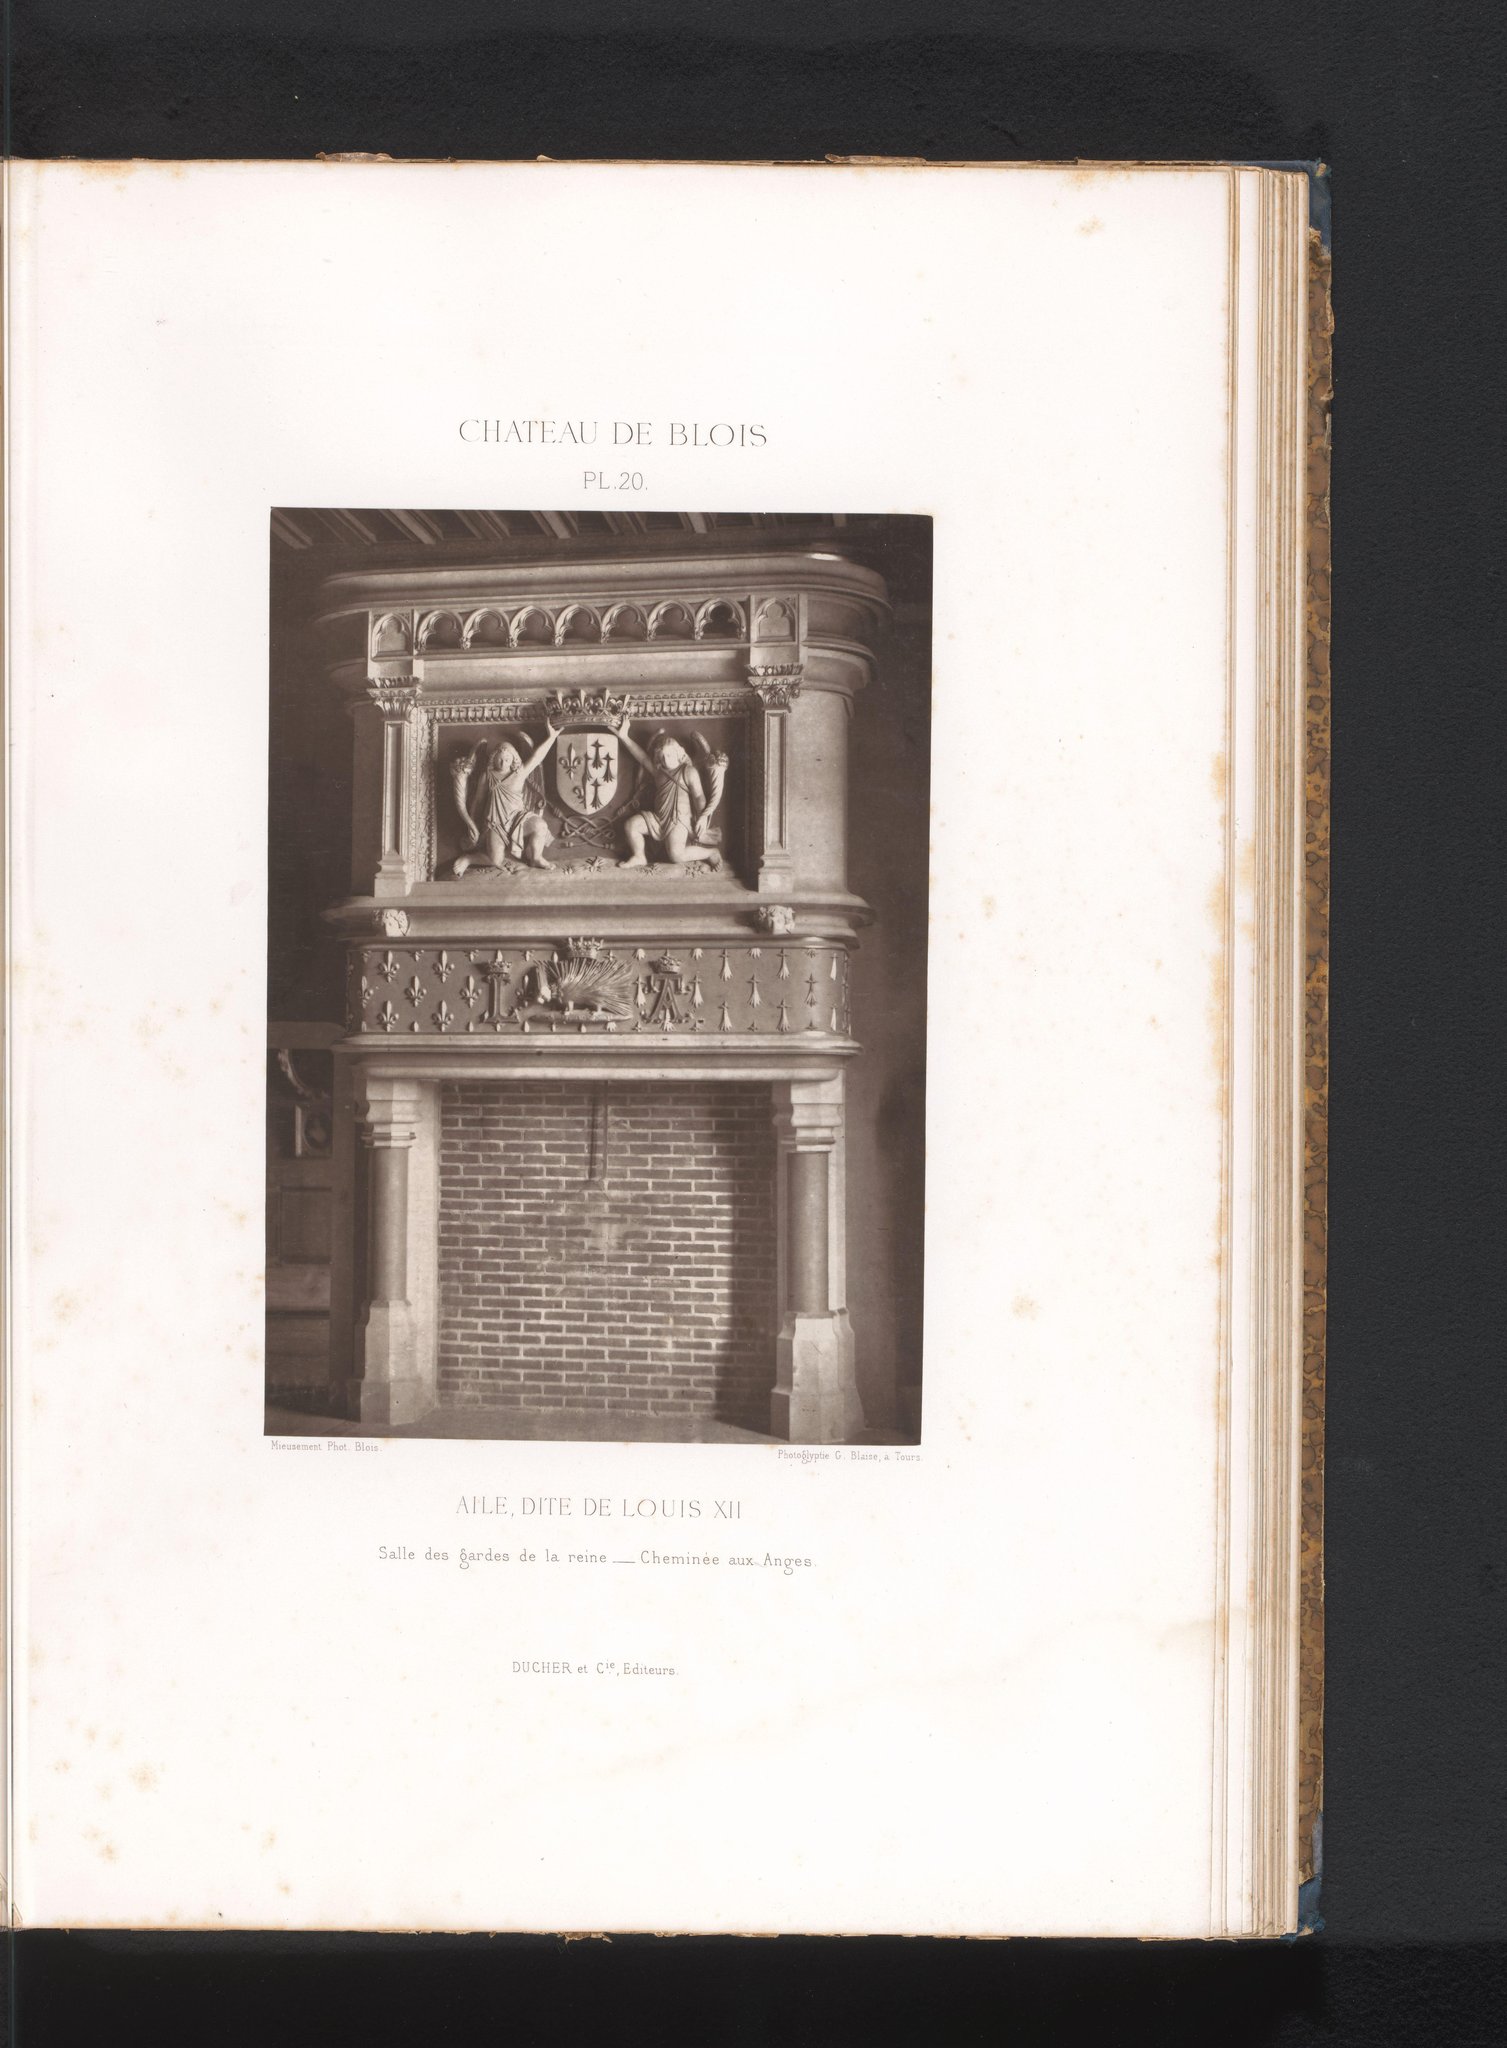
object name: page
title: Gezicht op een schoorsteenmantel in de Lodewijk XII vleugel van het Kasteel van Blois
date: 1870-1875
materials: paper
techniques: woodburytype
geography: tours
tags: castle, chimney-piece, mantelpiece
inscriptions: number: ‘PL. 20.’